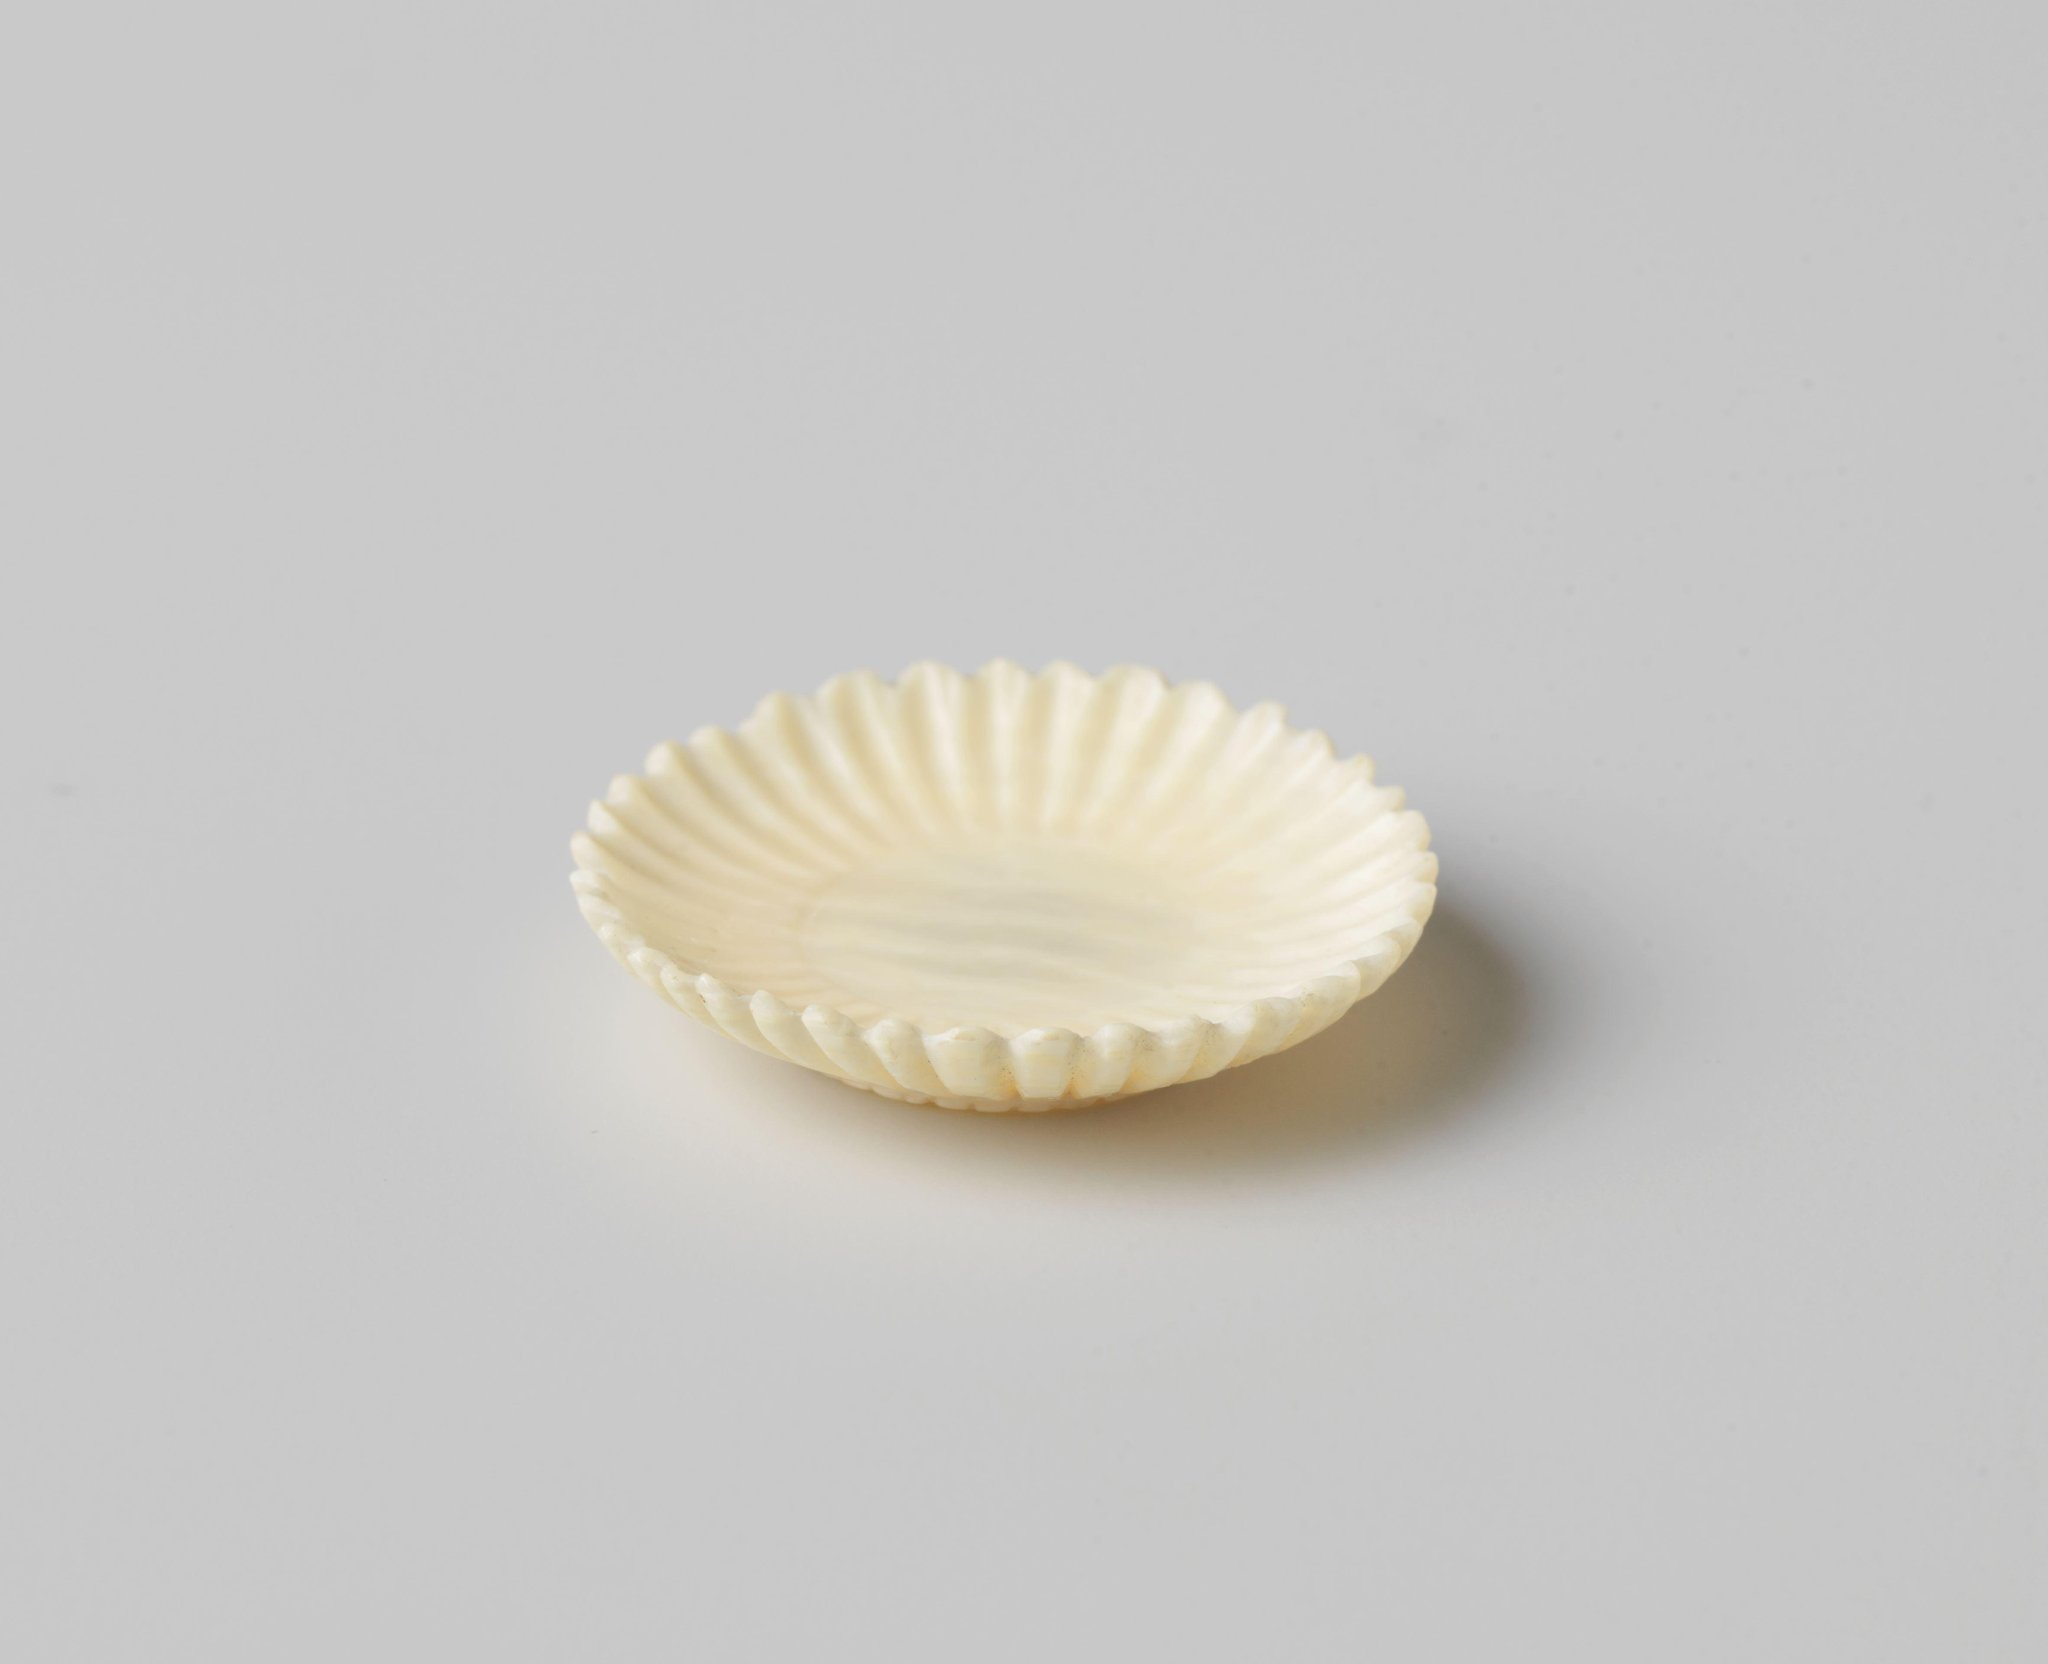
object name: platter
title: Schotel met geschulpte rand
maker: Anonymous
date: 1700-1799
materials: ivory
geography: germany